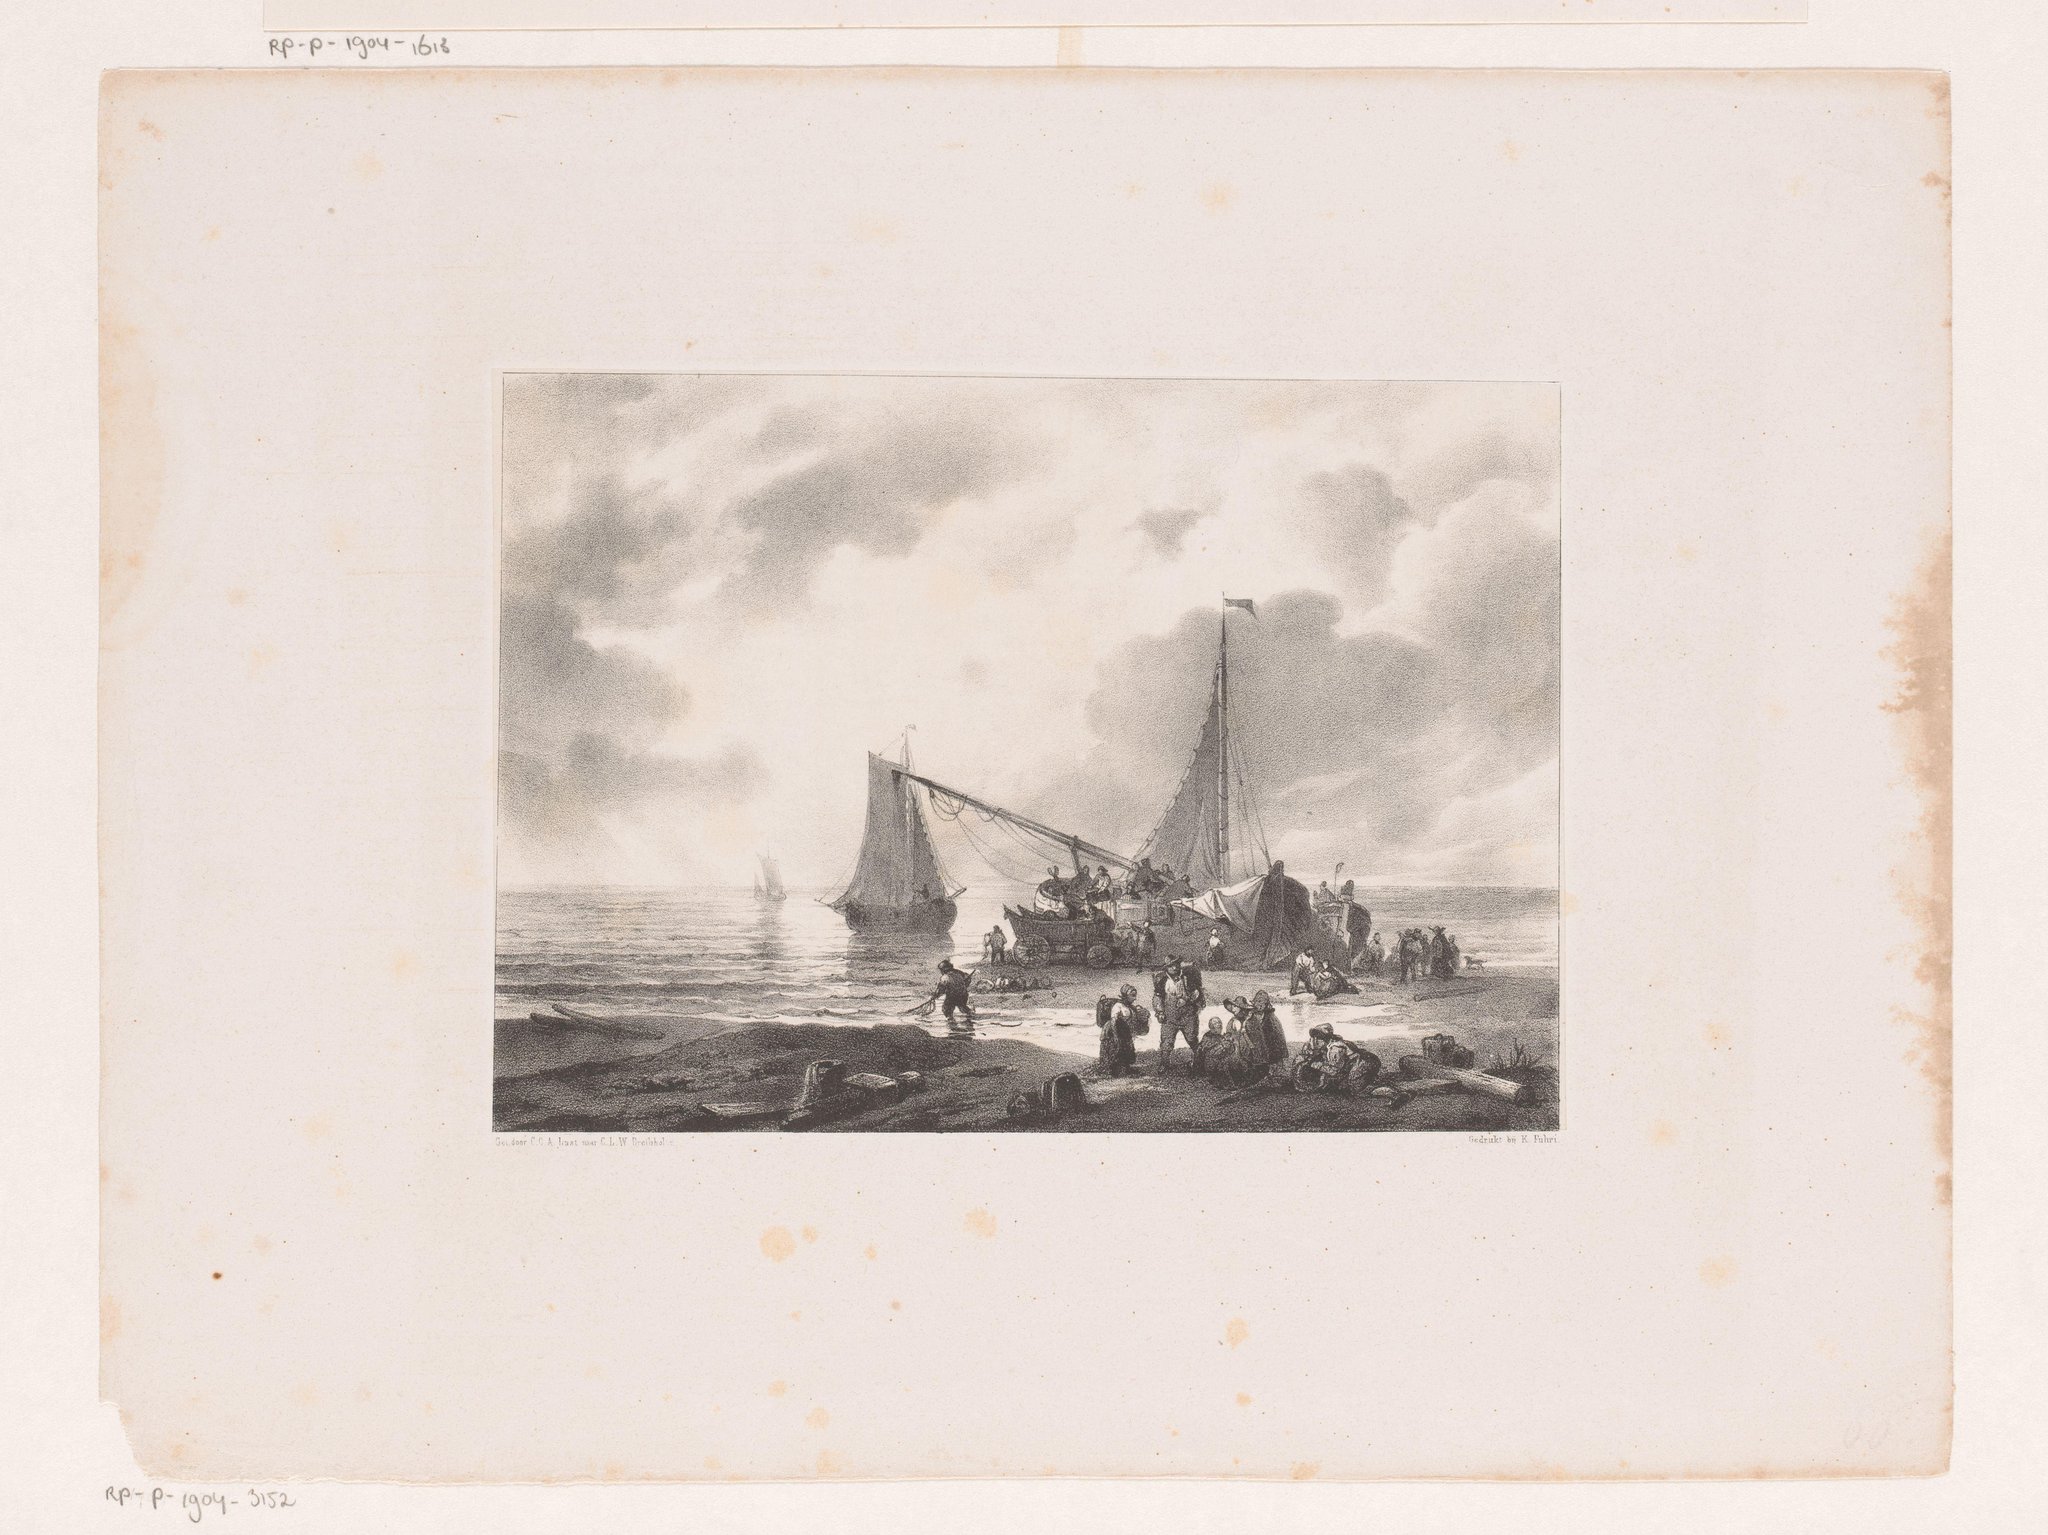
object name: print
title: Twee bomschuiten op het strand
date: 1837-1853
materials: paper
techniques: lithograph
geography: the hague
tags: sailing-ship, sailing-boat, ships, boats on land, beached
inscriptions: collector's mark: Lugt 2228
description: Van de voorste boot zijn de zeilen gestreken. Op zee nog twee zeilboten.